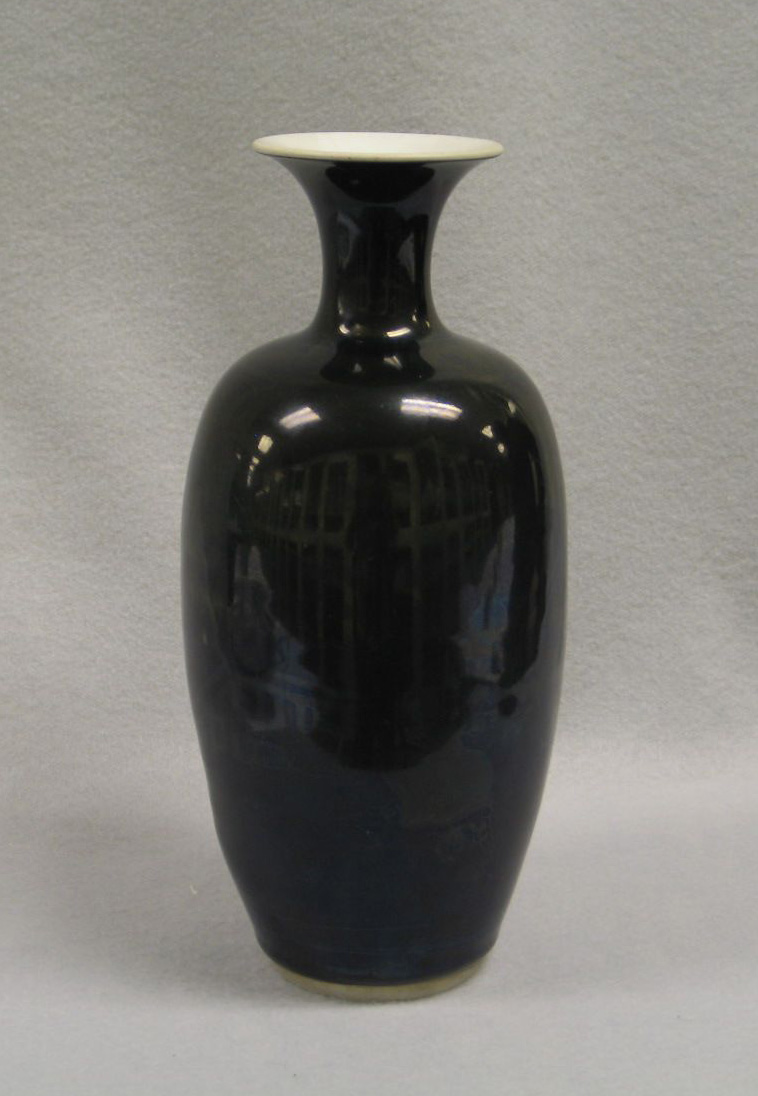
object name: bottle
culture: chinese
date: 1662-1722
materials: porcelain